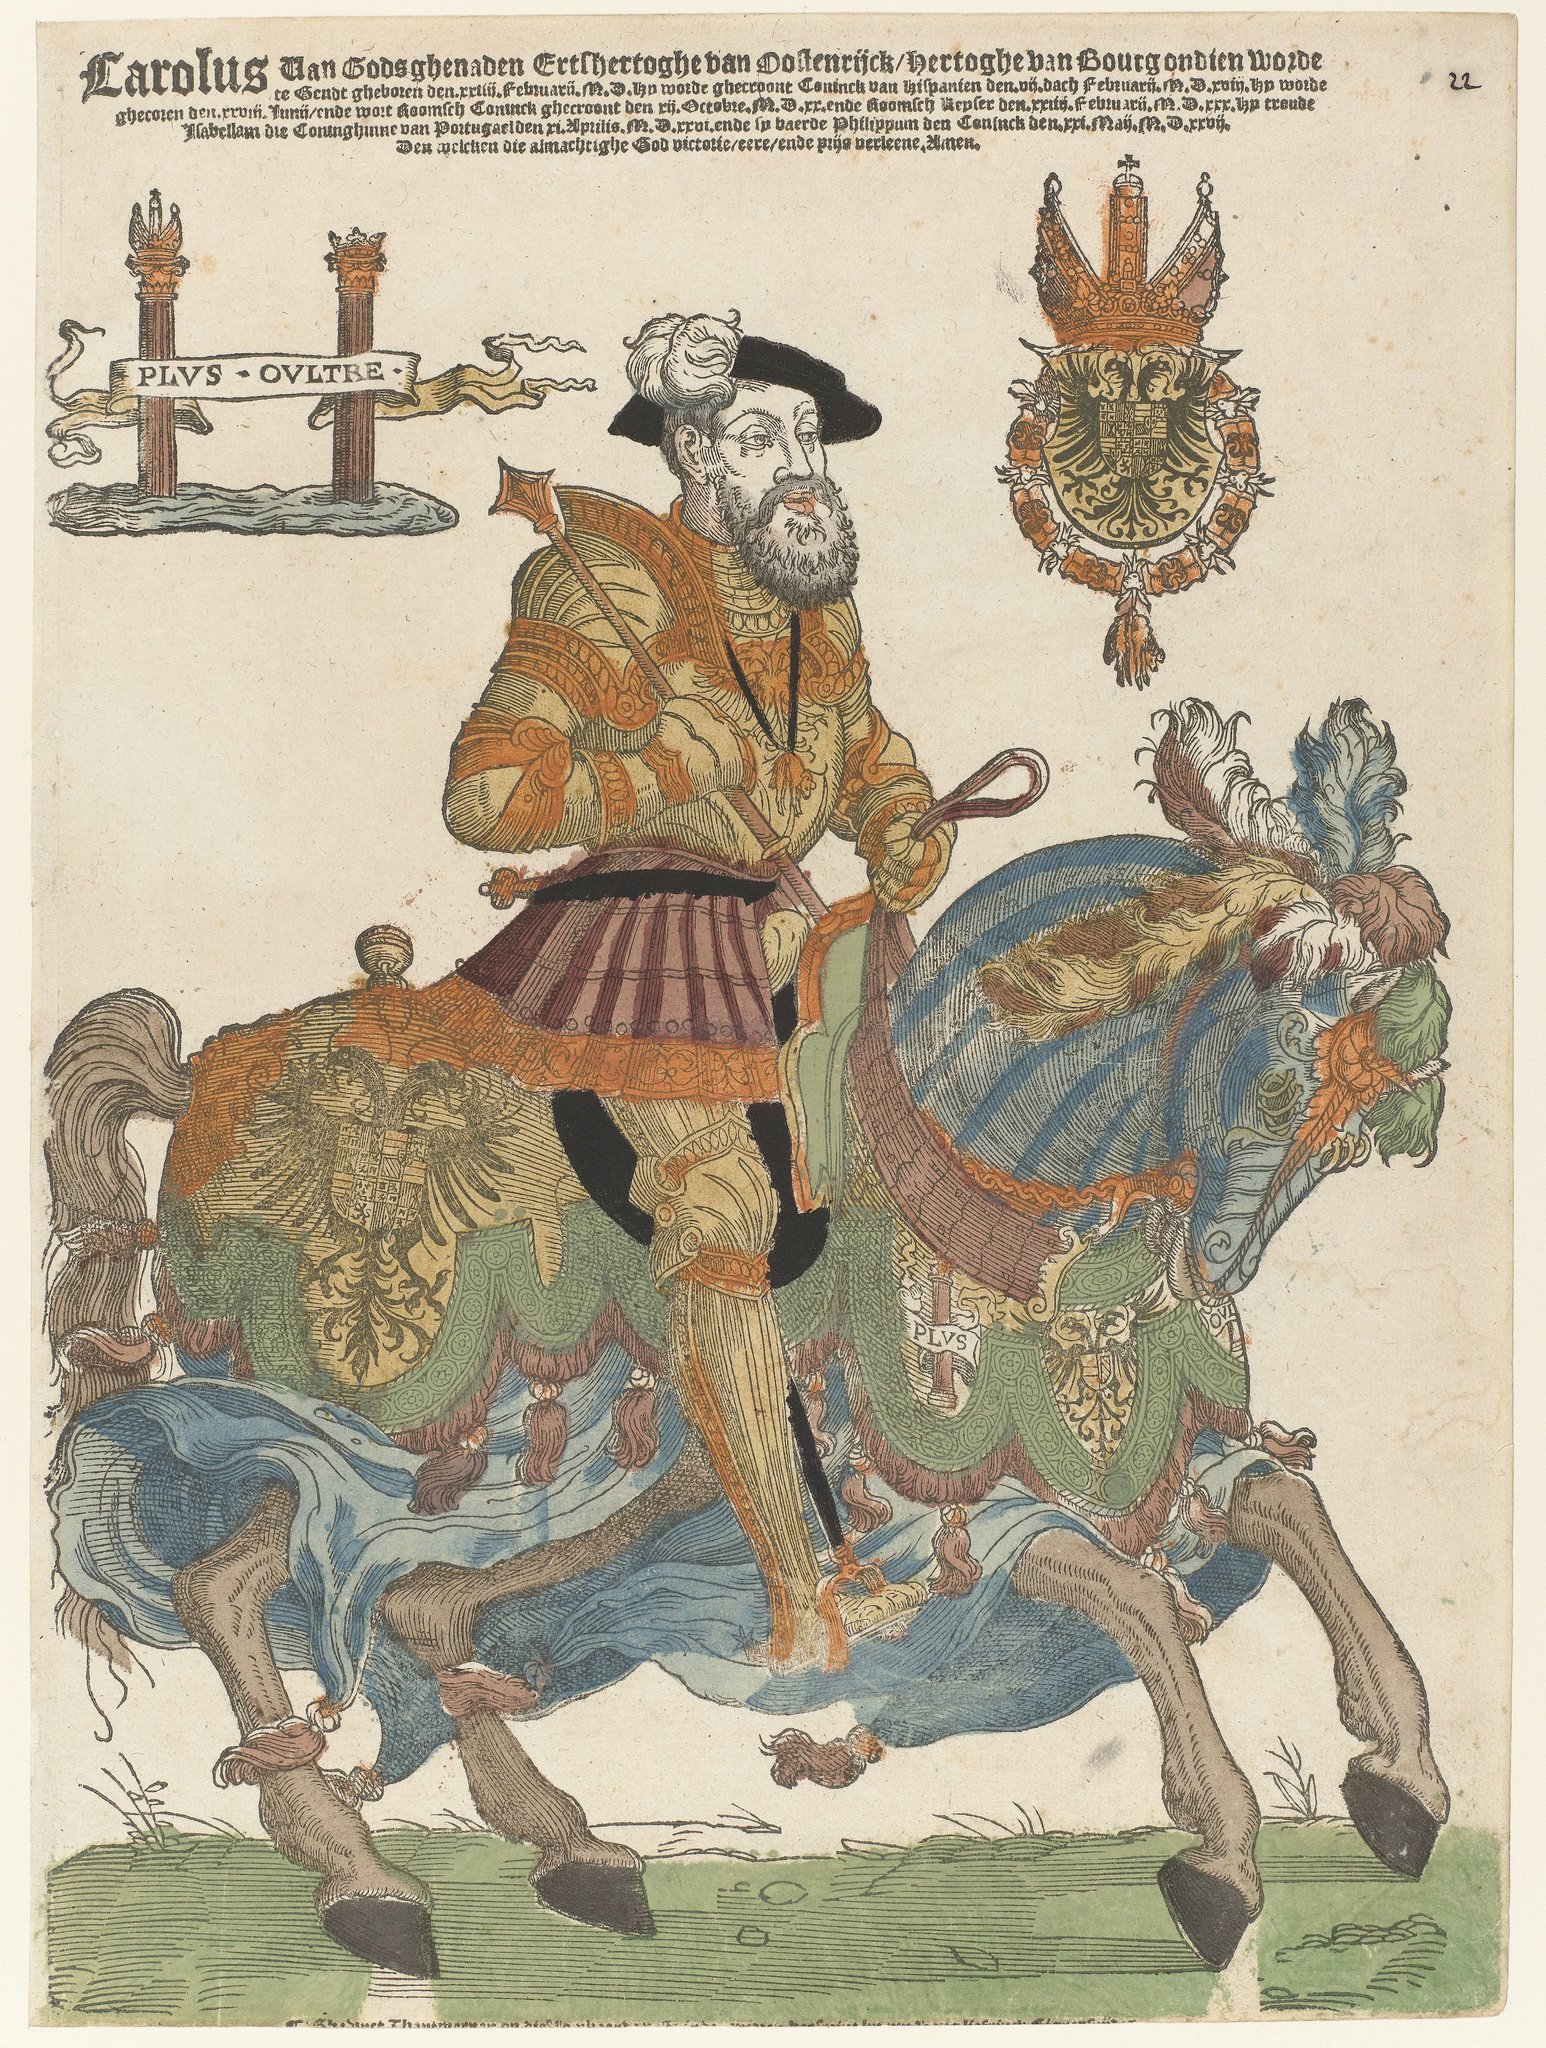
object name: print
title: Ruiterportret van keizer Karel V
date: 1539-1556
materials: paper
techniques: hand coloring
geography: antwerp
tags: ghent, charles v (holy roman emperor and king of spain), equestrian state-portrait, historical persons, emperor, armorial bearing, heraldry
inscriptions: number: ‘22’, motto: ‘PLVS OVLTRE’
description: Karel V (1500-1558) als ruiter. Ruiter en paard in wapenrusting, in galop. Wapenrusting met harnas en staf, pantser en pluimen, wapenkleed en onderkleed met vliegende kwasten. Rechtsboven het Rijkswapen met de Orde van het Gulden Vlies. Linksboven zijn embleem: de twee zuilen van Hercules en devies PLUS OULTRE.